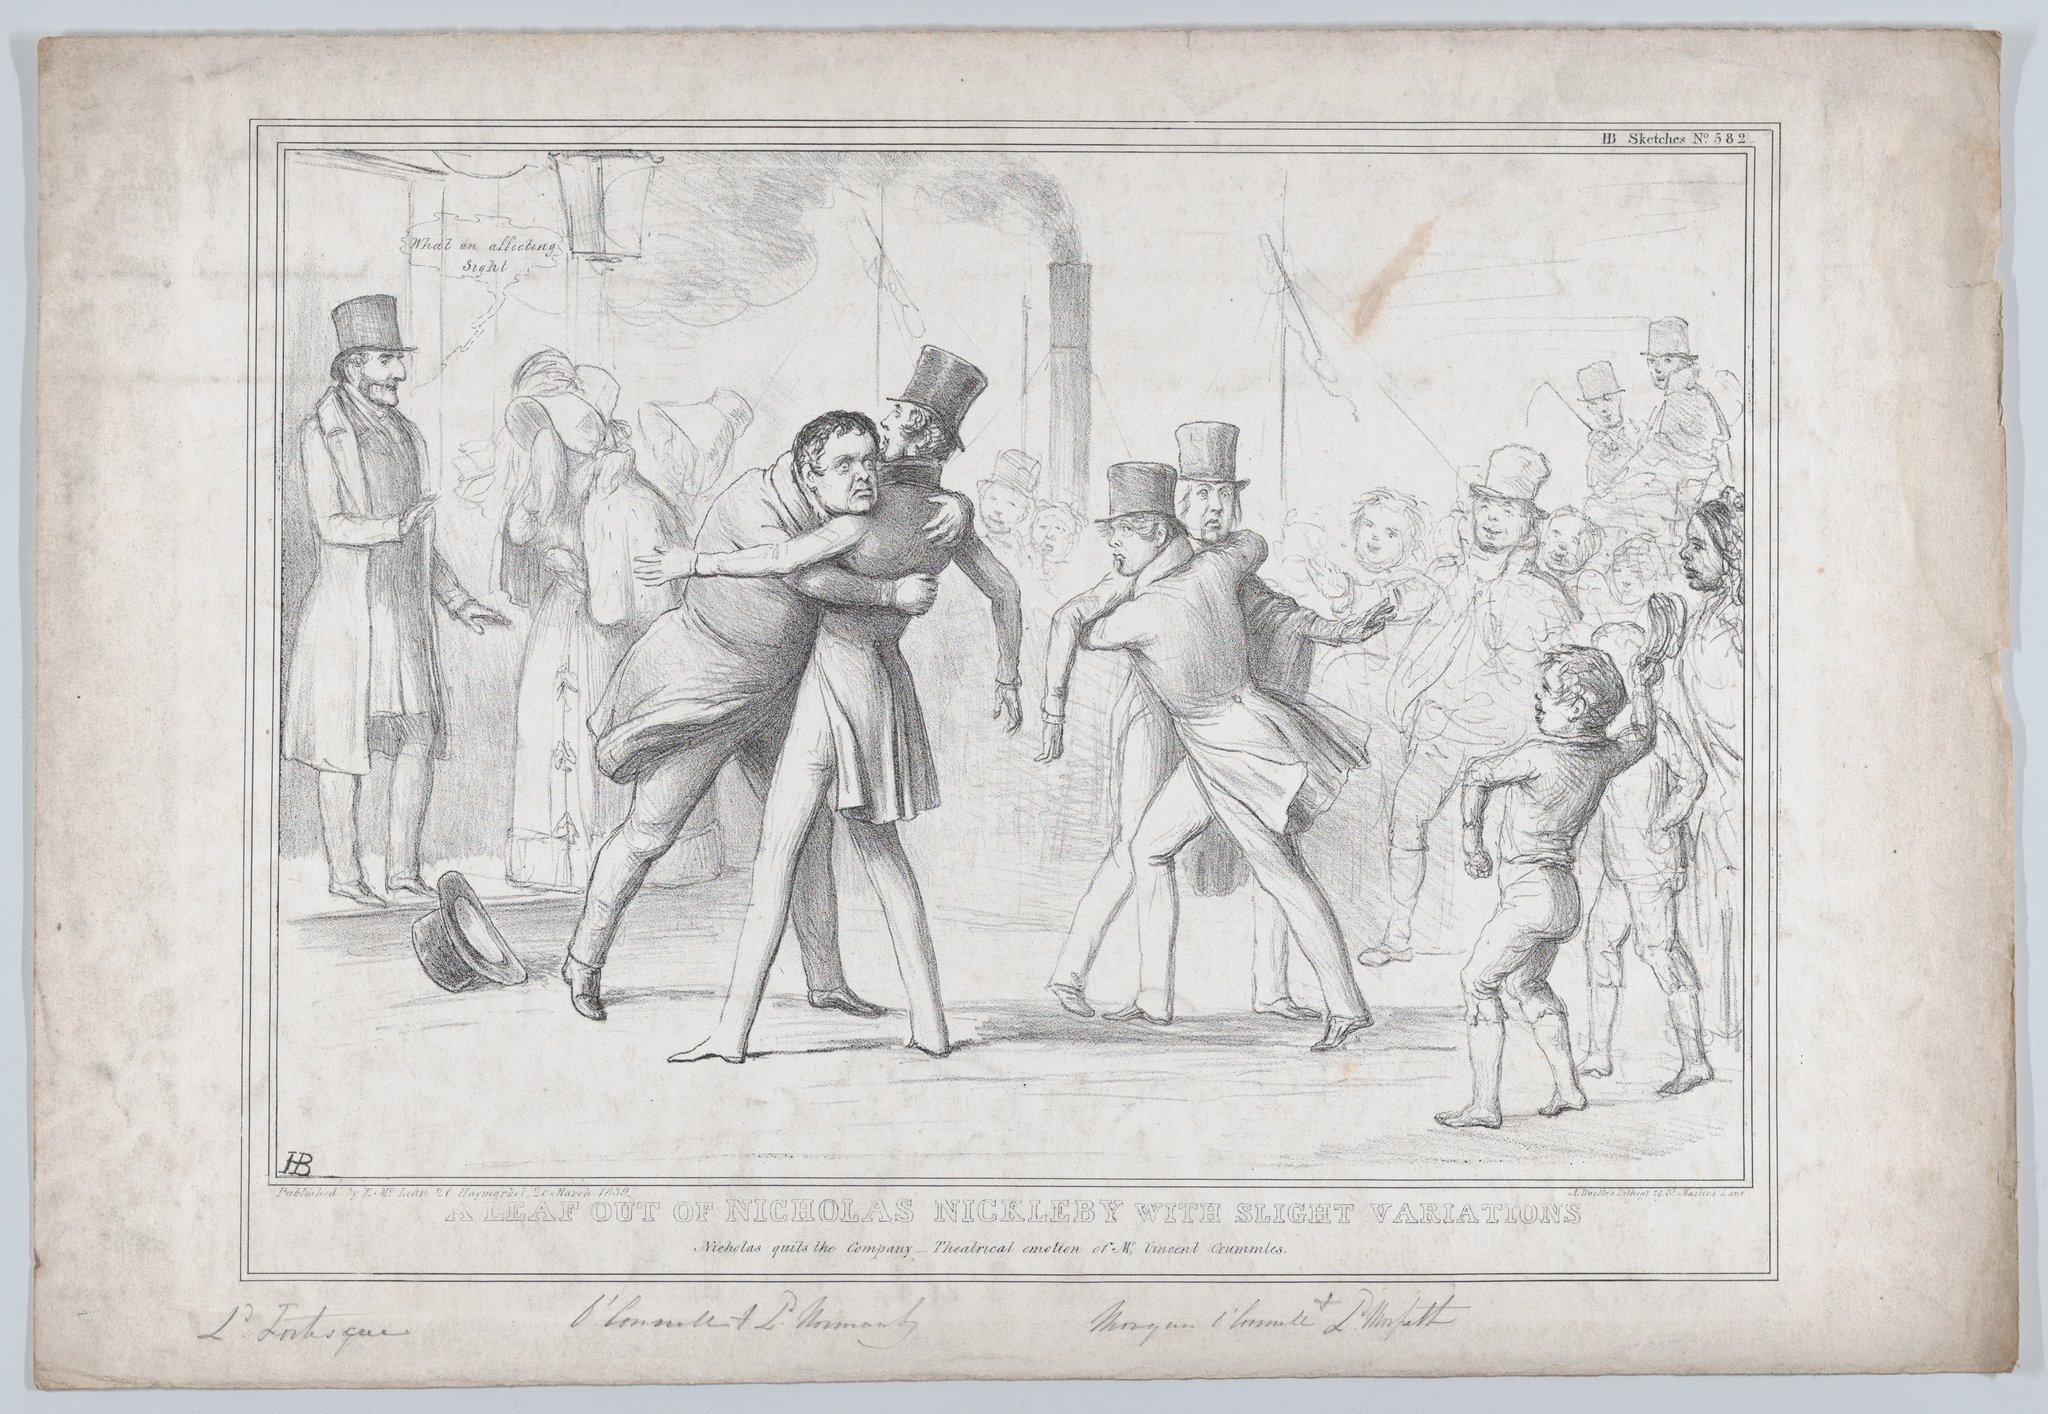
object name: print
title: A Leaf Out of Nicholas Nickleby with Slight Variations – Nicholas quits the Company – Theatrical Emotion of Mr. Vincent Crummles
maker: john doyle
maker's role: artist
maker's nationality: irish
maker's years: 1797-1868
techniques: lithograph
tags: boys,men,women,actors